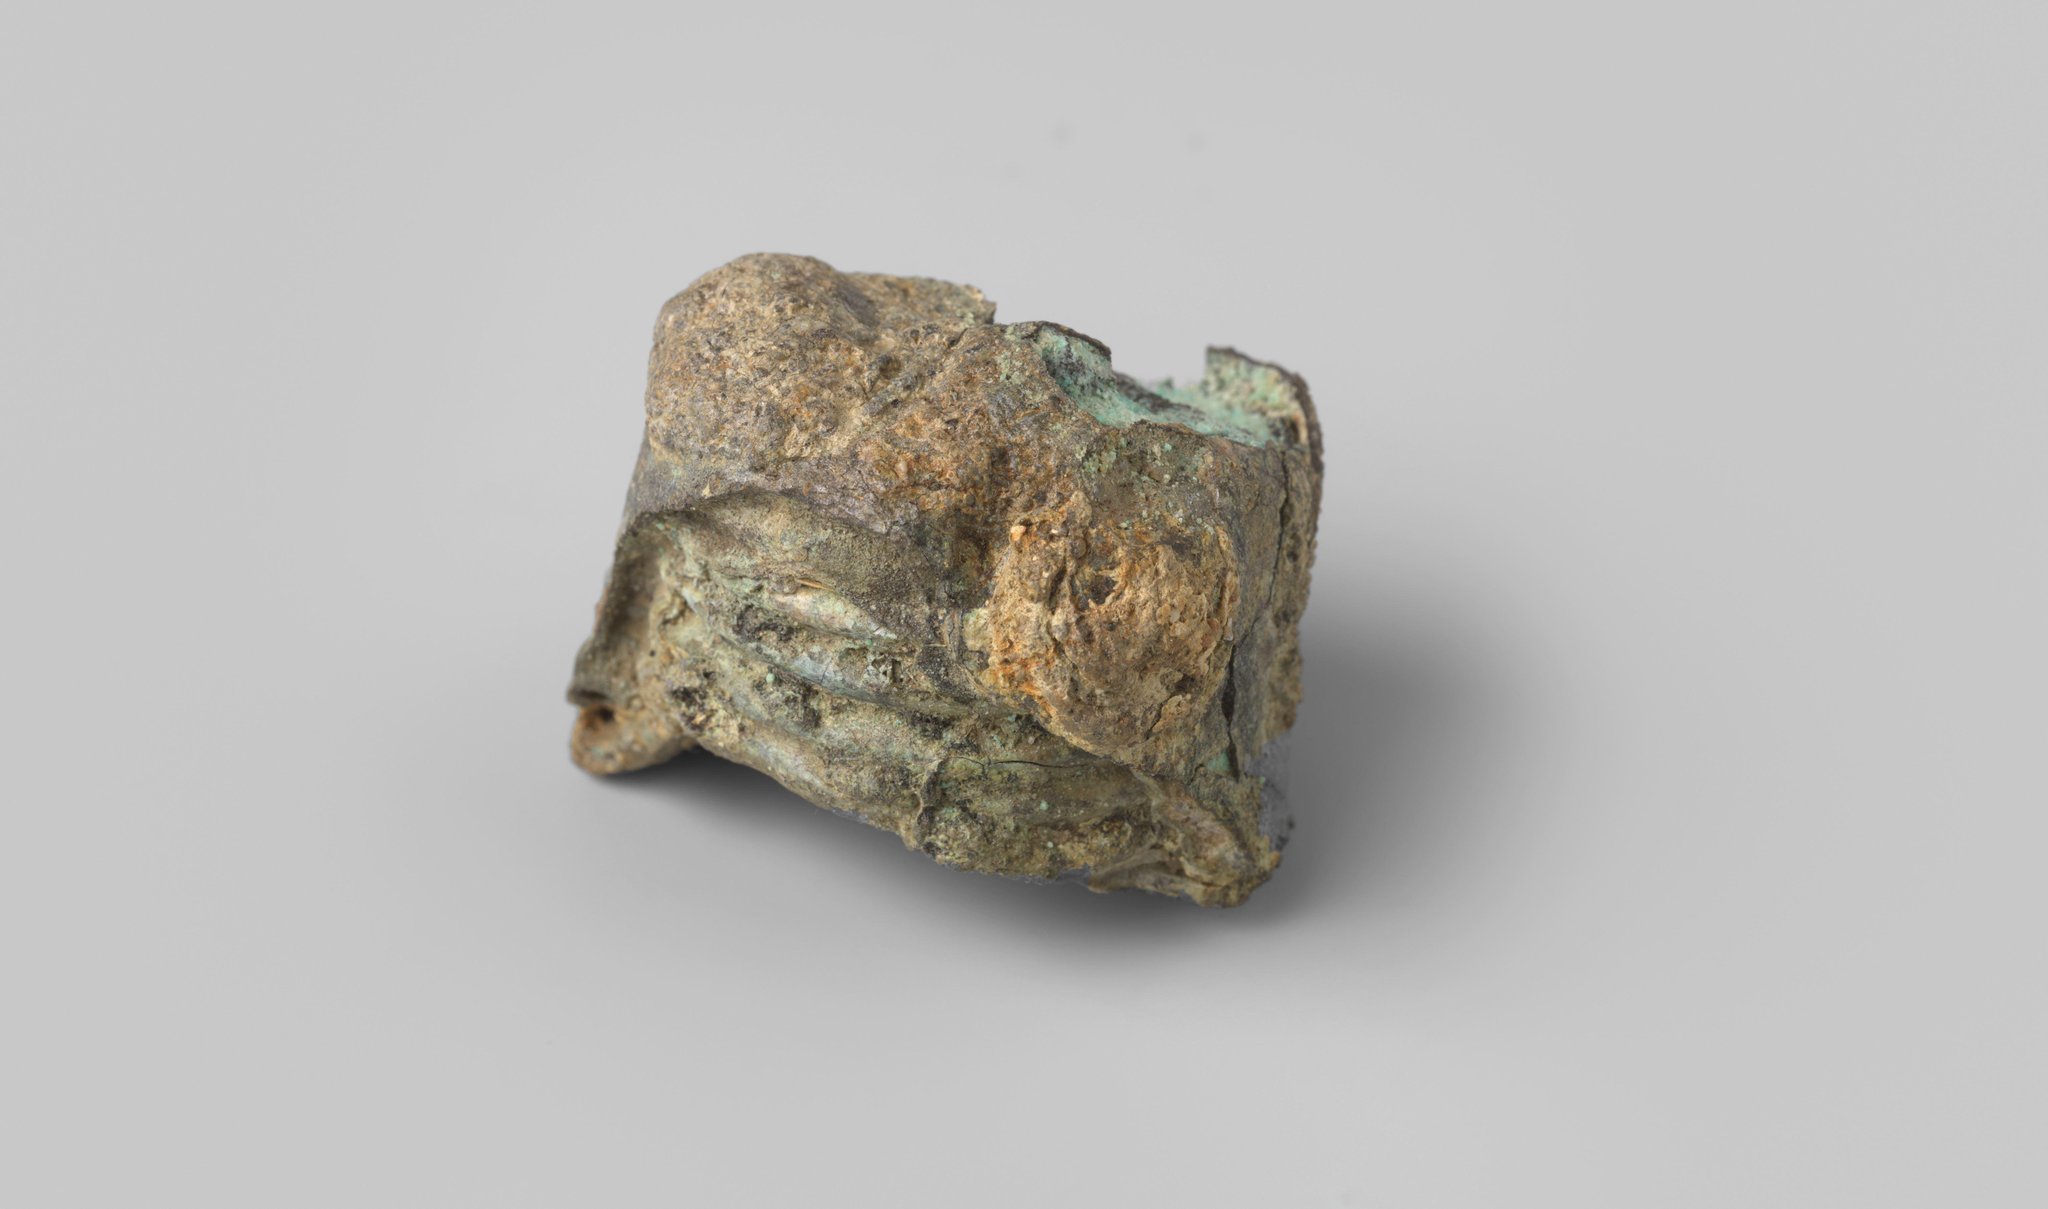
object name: screw in socket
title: Schroefdop en -fitting uit het wrak van de Oost-Indiëvaarder Hollandia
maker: Anonymous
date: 1700-1743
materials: tin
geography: netherlands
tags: verenigde oostindische compagnie, hollandia (schip), annet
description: Container, screw cap and fitting; fragm of stub and cap, id. NG 1980-27H119, corroded.